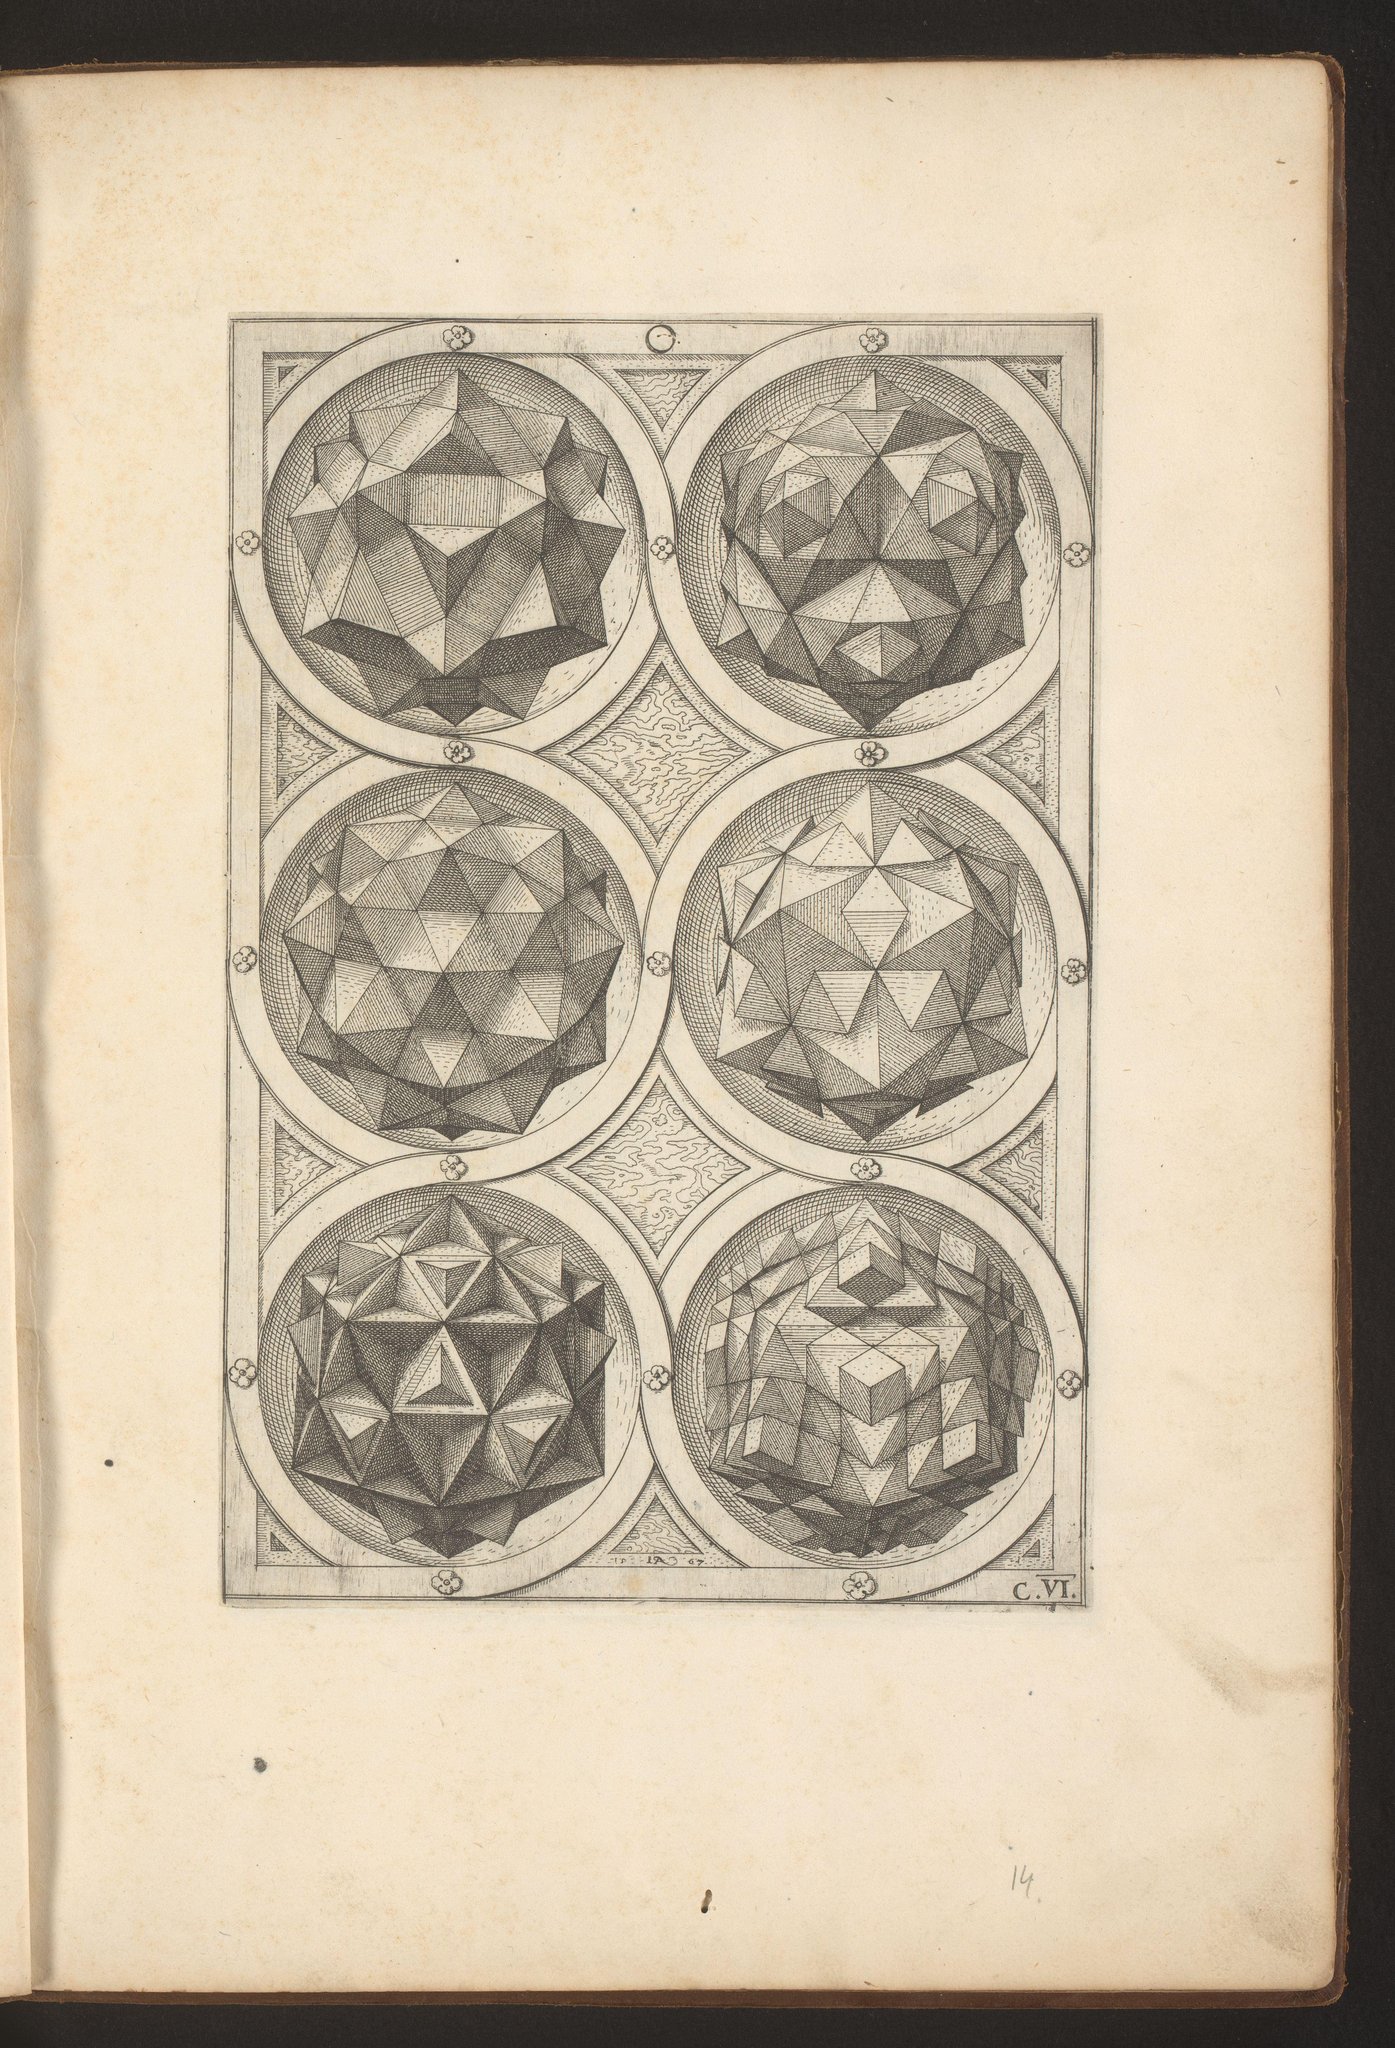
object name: book illustration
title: Zes veelvlakken met een icosaëder als uitgangspunt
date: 1568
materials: paper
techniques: etching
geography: nuremberg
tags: other polyhedrons, icosahedron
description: De geometrische figuren (polyhedra) worden van boven naar beneden complexer. Rechtsonder genummerd: C.VI. Deze prent maakt deel uit van een boek.